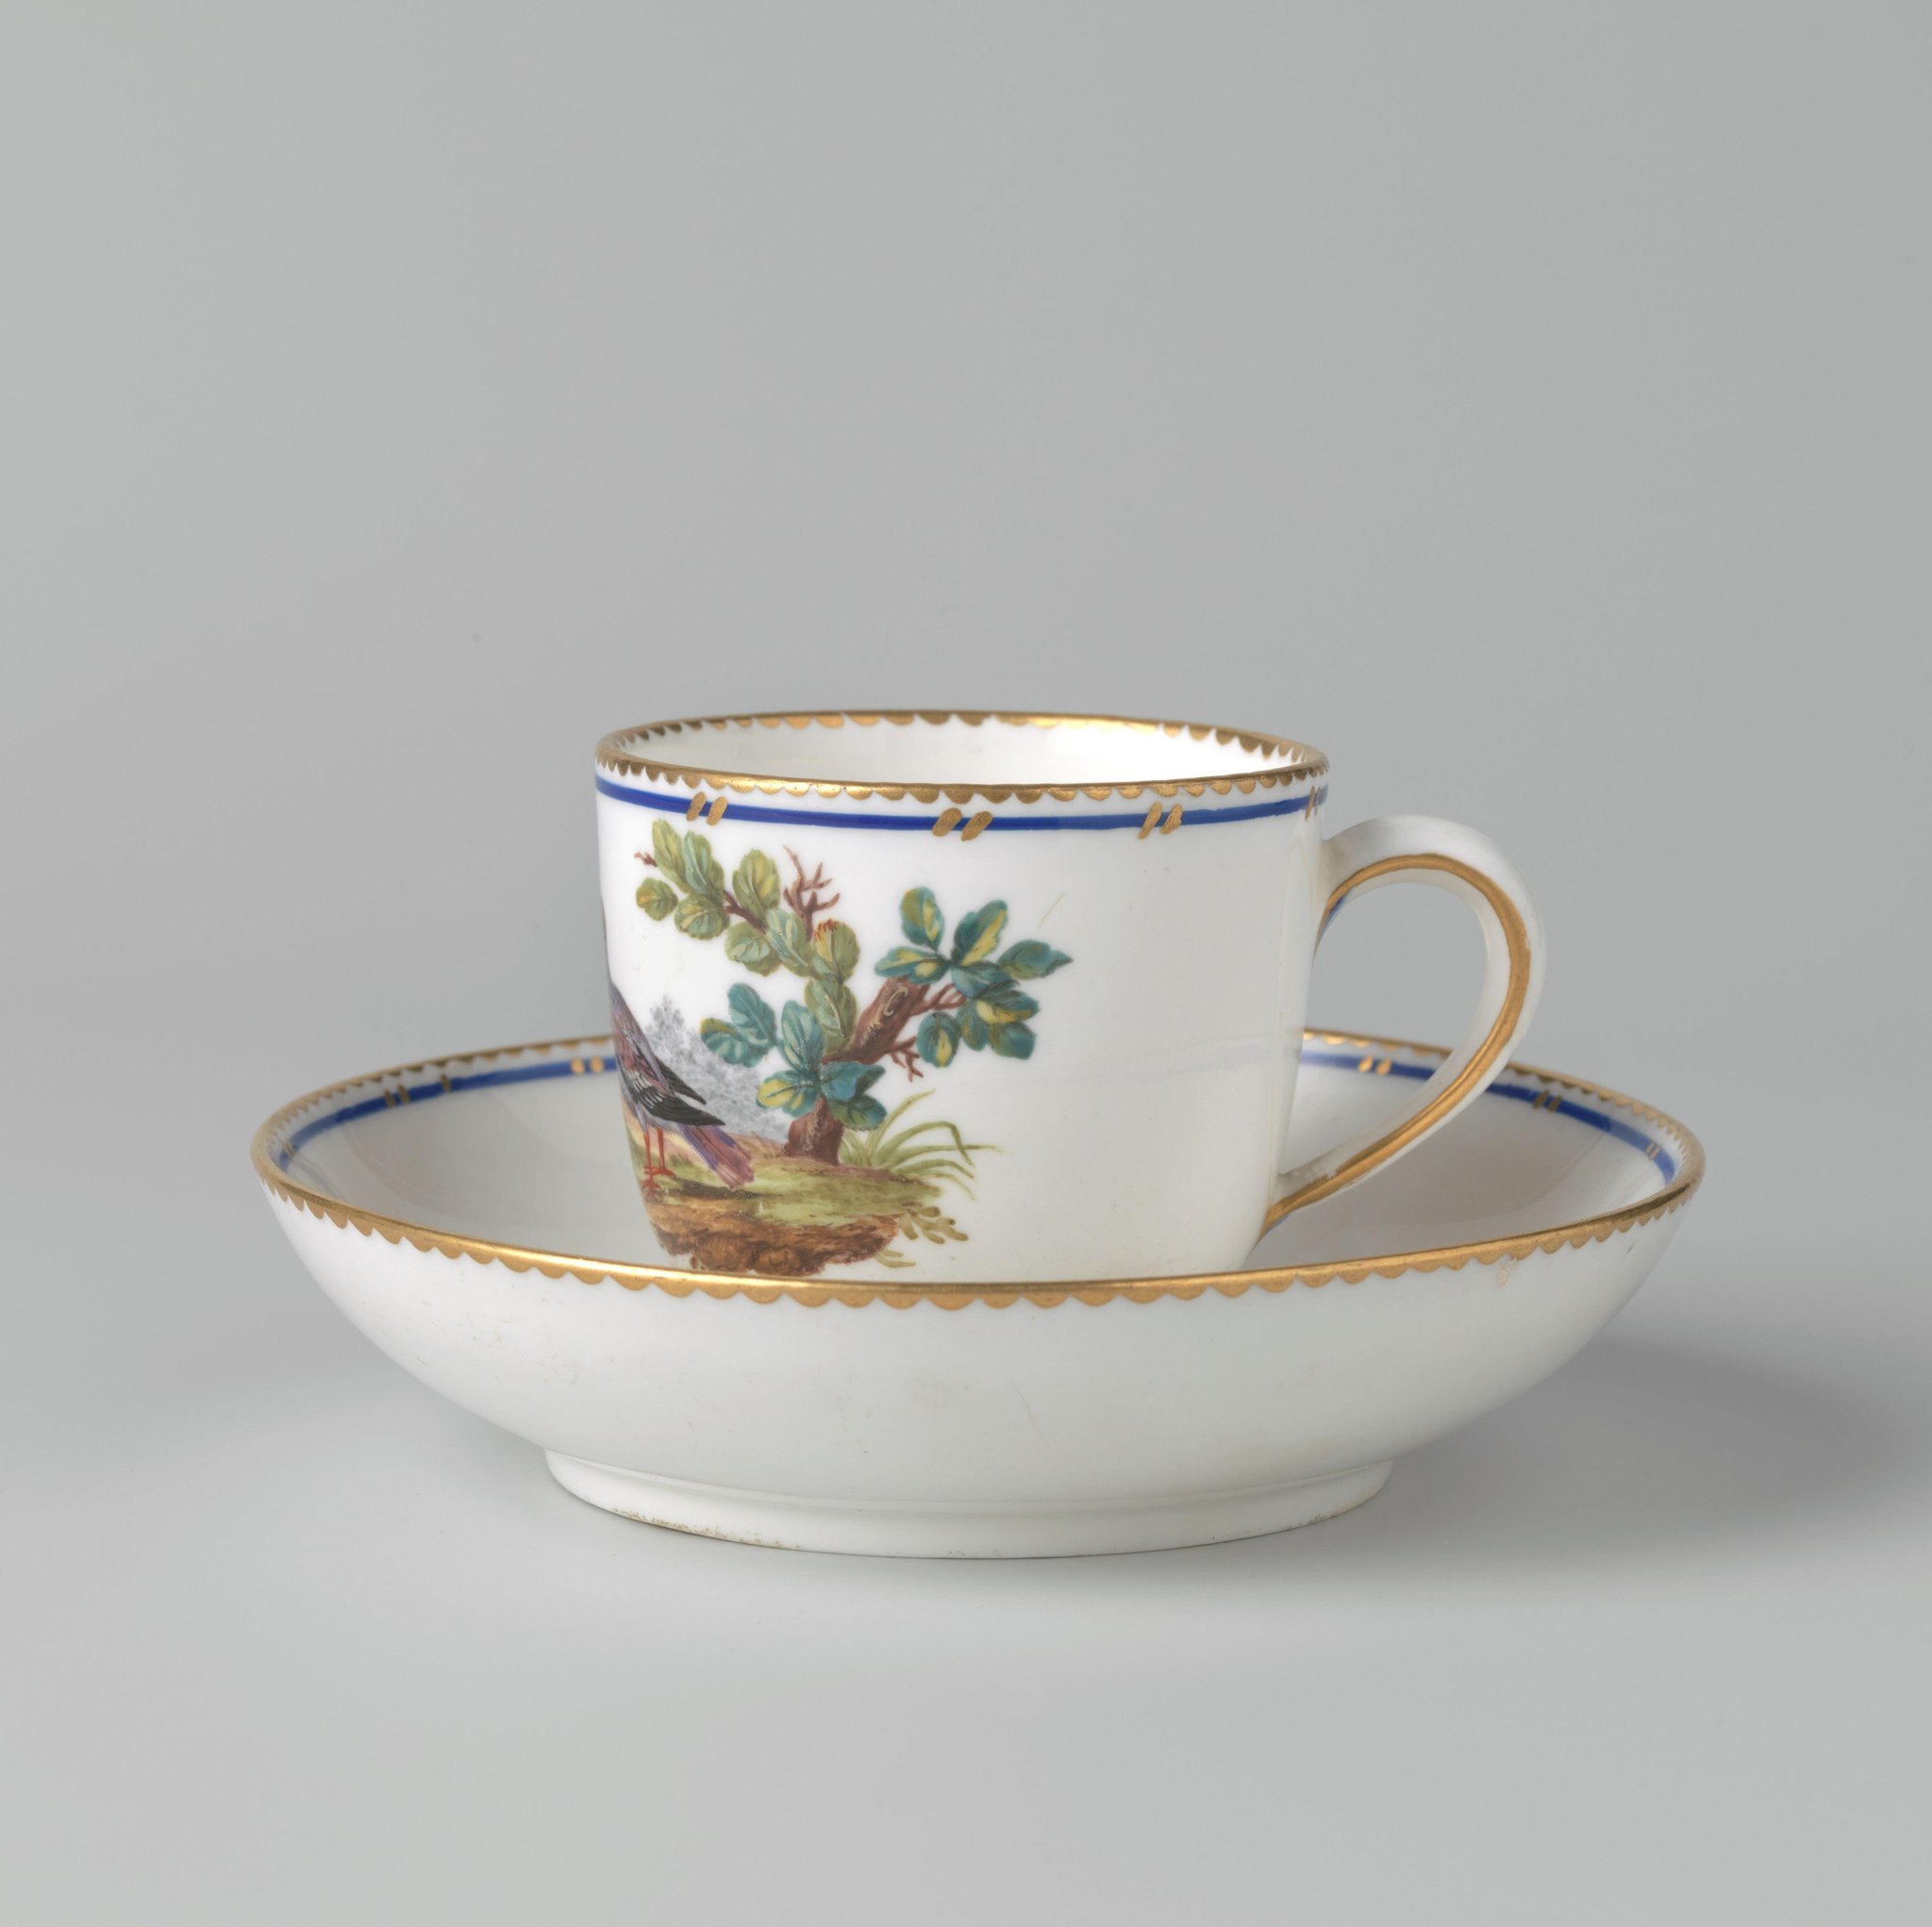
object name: platter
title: Saucer with a bird in a landscape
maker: Anonymous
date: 1750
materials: glaze, gold, paint, porcelain, soft paste porcelain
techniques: firing, forming, gilding, turning, vitrification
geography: vincennes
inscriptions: mark: ‘dubbele L/ X/ da’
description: Schotel van soft-paste porselein (pâte tendre), beschilderd op het glazuur in emailkleuren en goud. Op het plat een vogel op een tak in een landschap met bomen en planten. Op de voet en de binnenrand een blauwe lijn met telkens twee schuine, gouden strepen. Op de rand, aan de binnen- en buitenzijde een band van halve gouden bollen. Gemerkt op de onderzijde met de dubbele L, X en da.